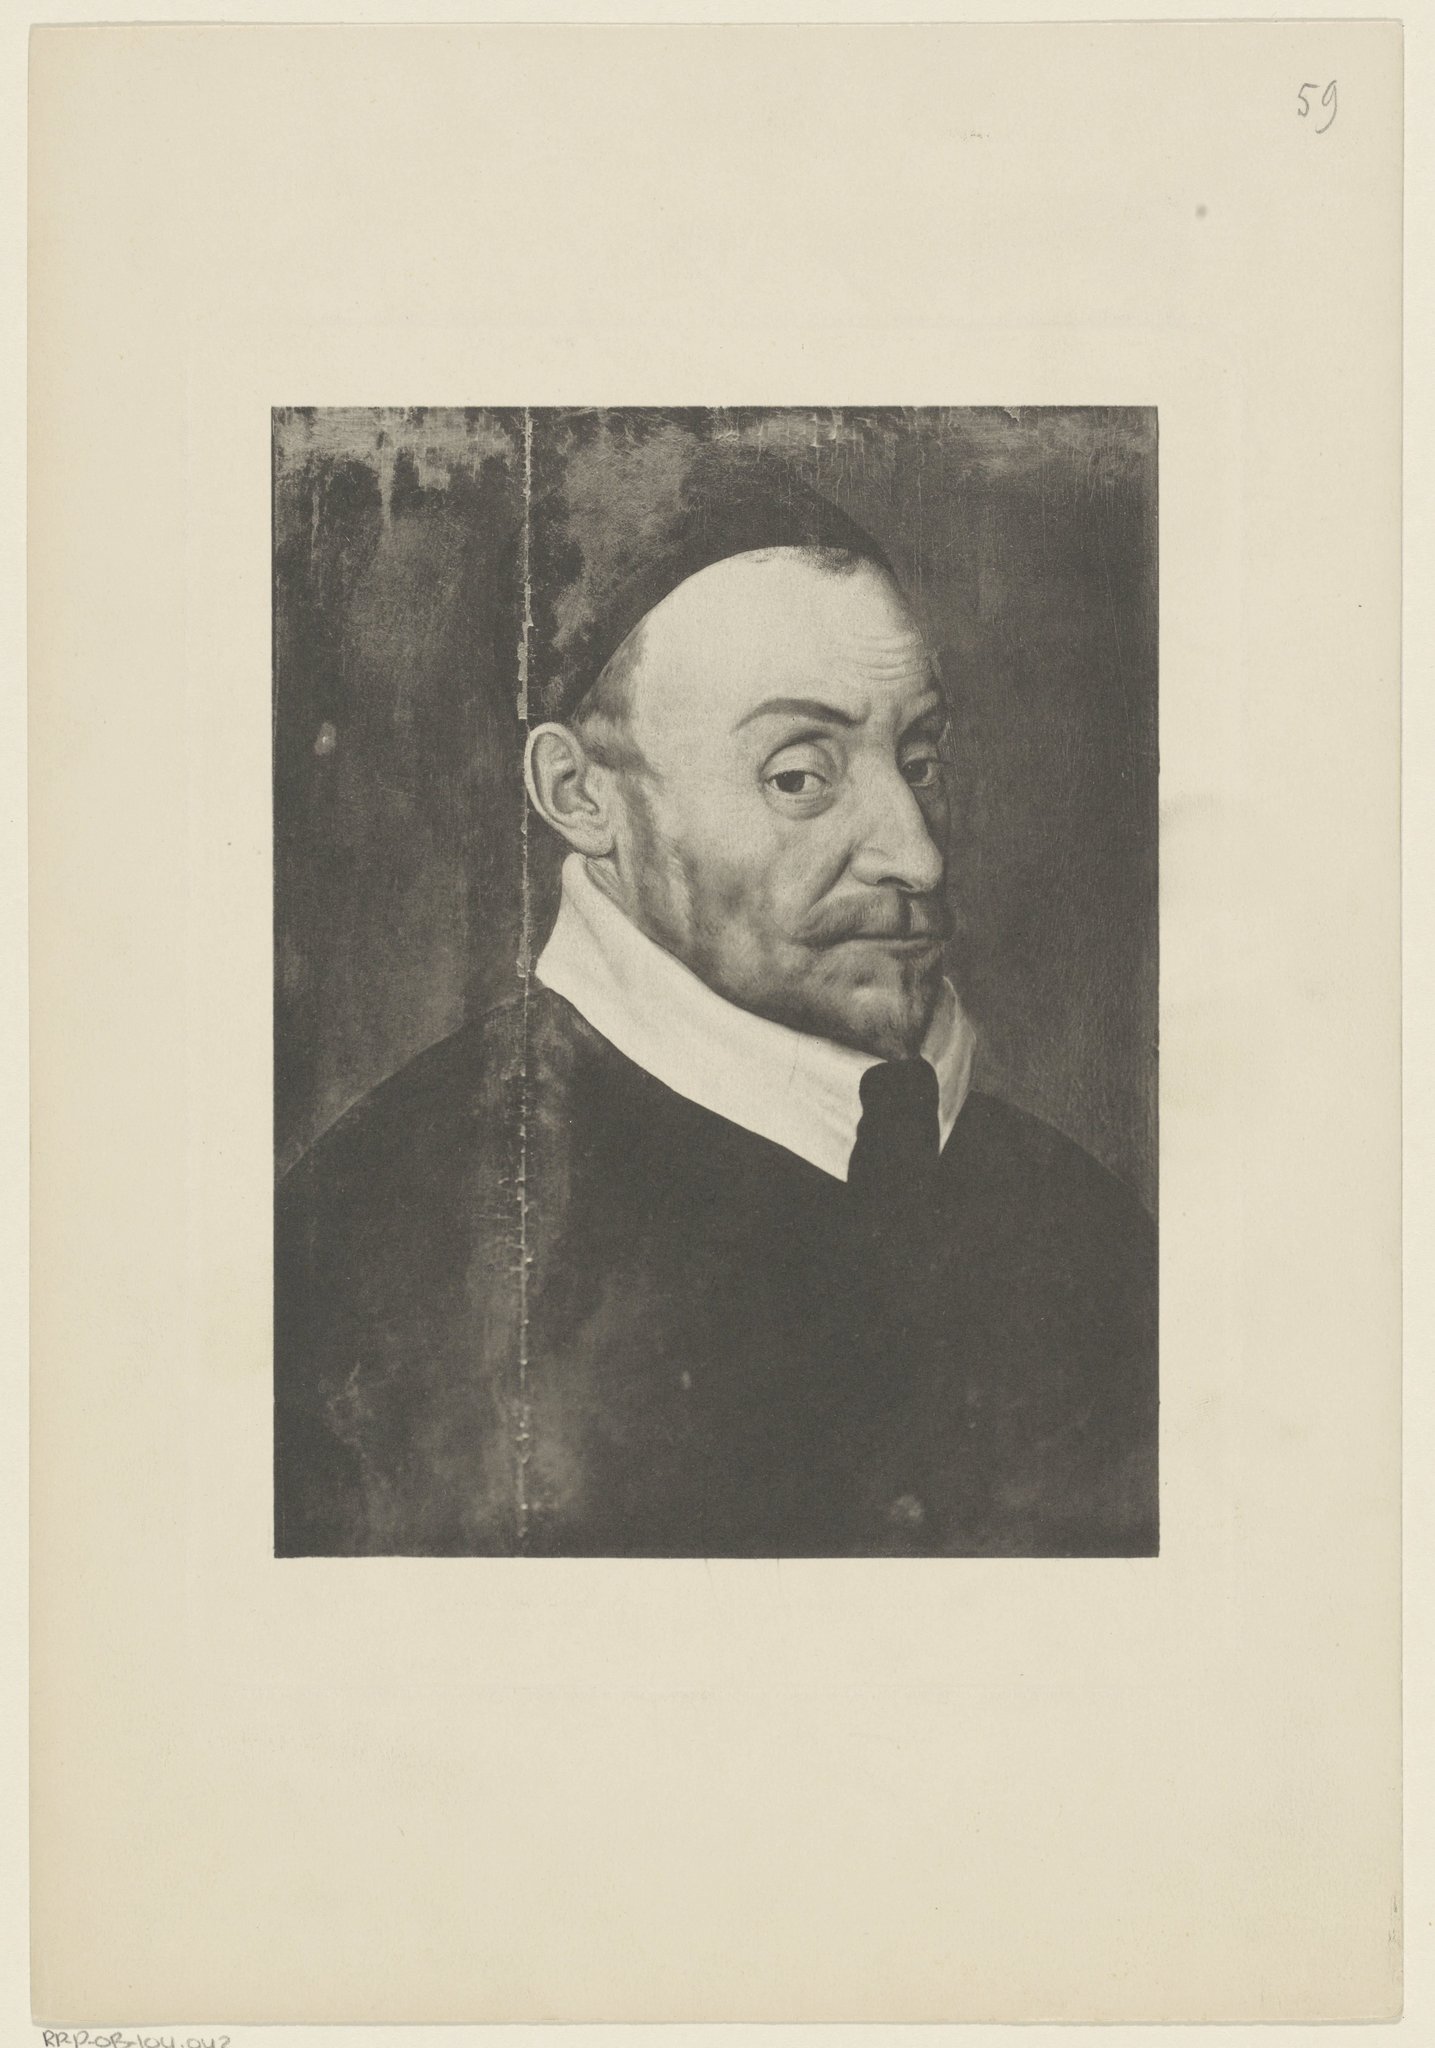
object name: photomechanical print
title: Portret van Willem I, prins van Oranje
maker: Anonymous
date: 1850-1949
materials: paper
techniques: photochemical processes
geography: low countries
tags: delft, william i (prince of orange)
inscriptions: collector's mark: Lugt 2228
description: De hier vermelde titel verwijst naar de hoogst verkregen titel van de geportretteerde, niet per se naar de titel die de geportretteerde op deze voorstelling draagt.